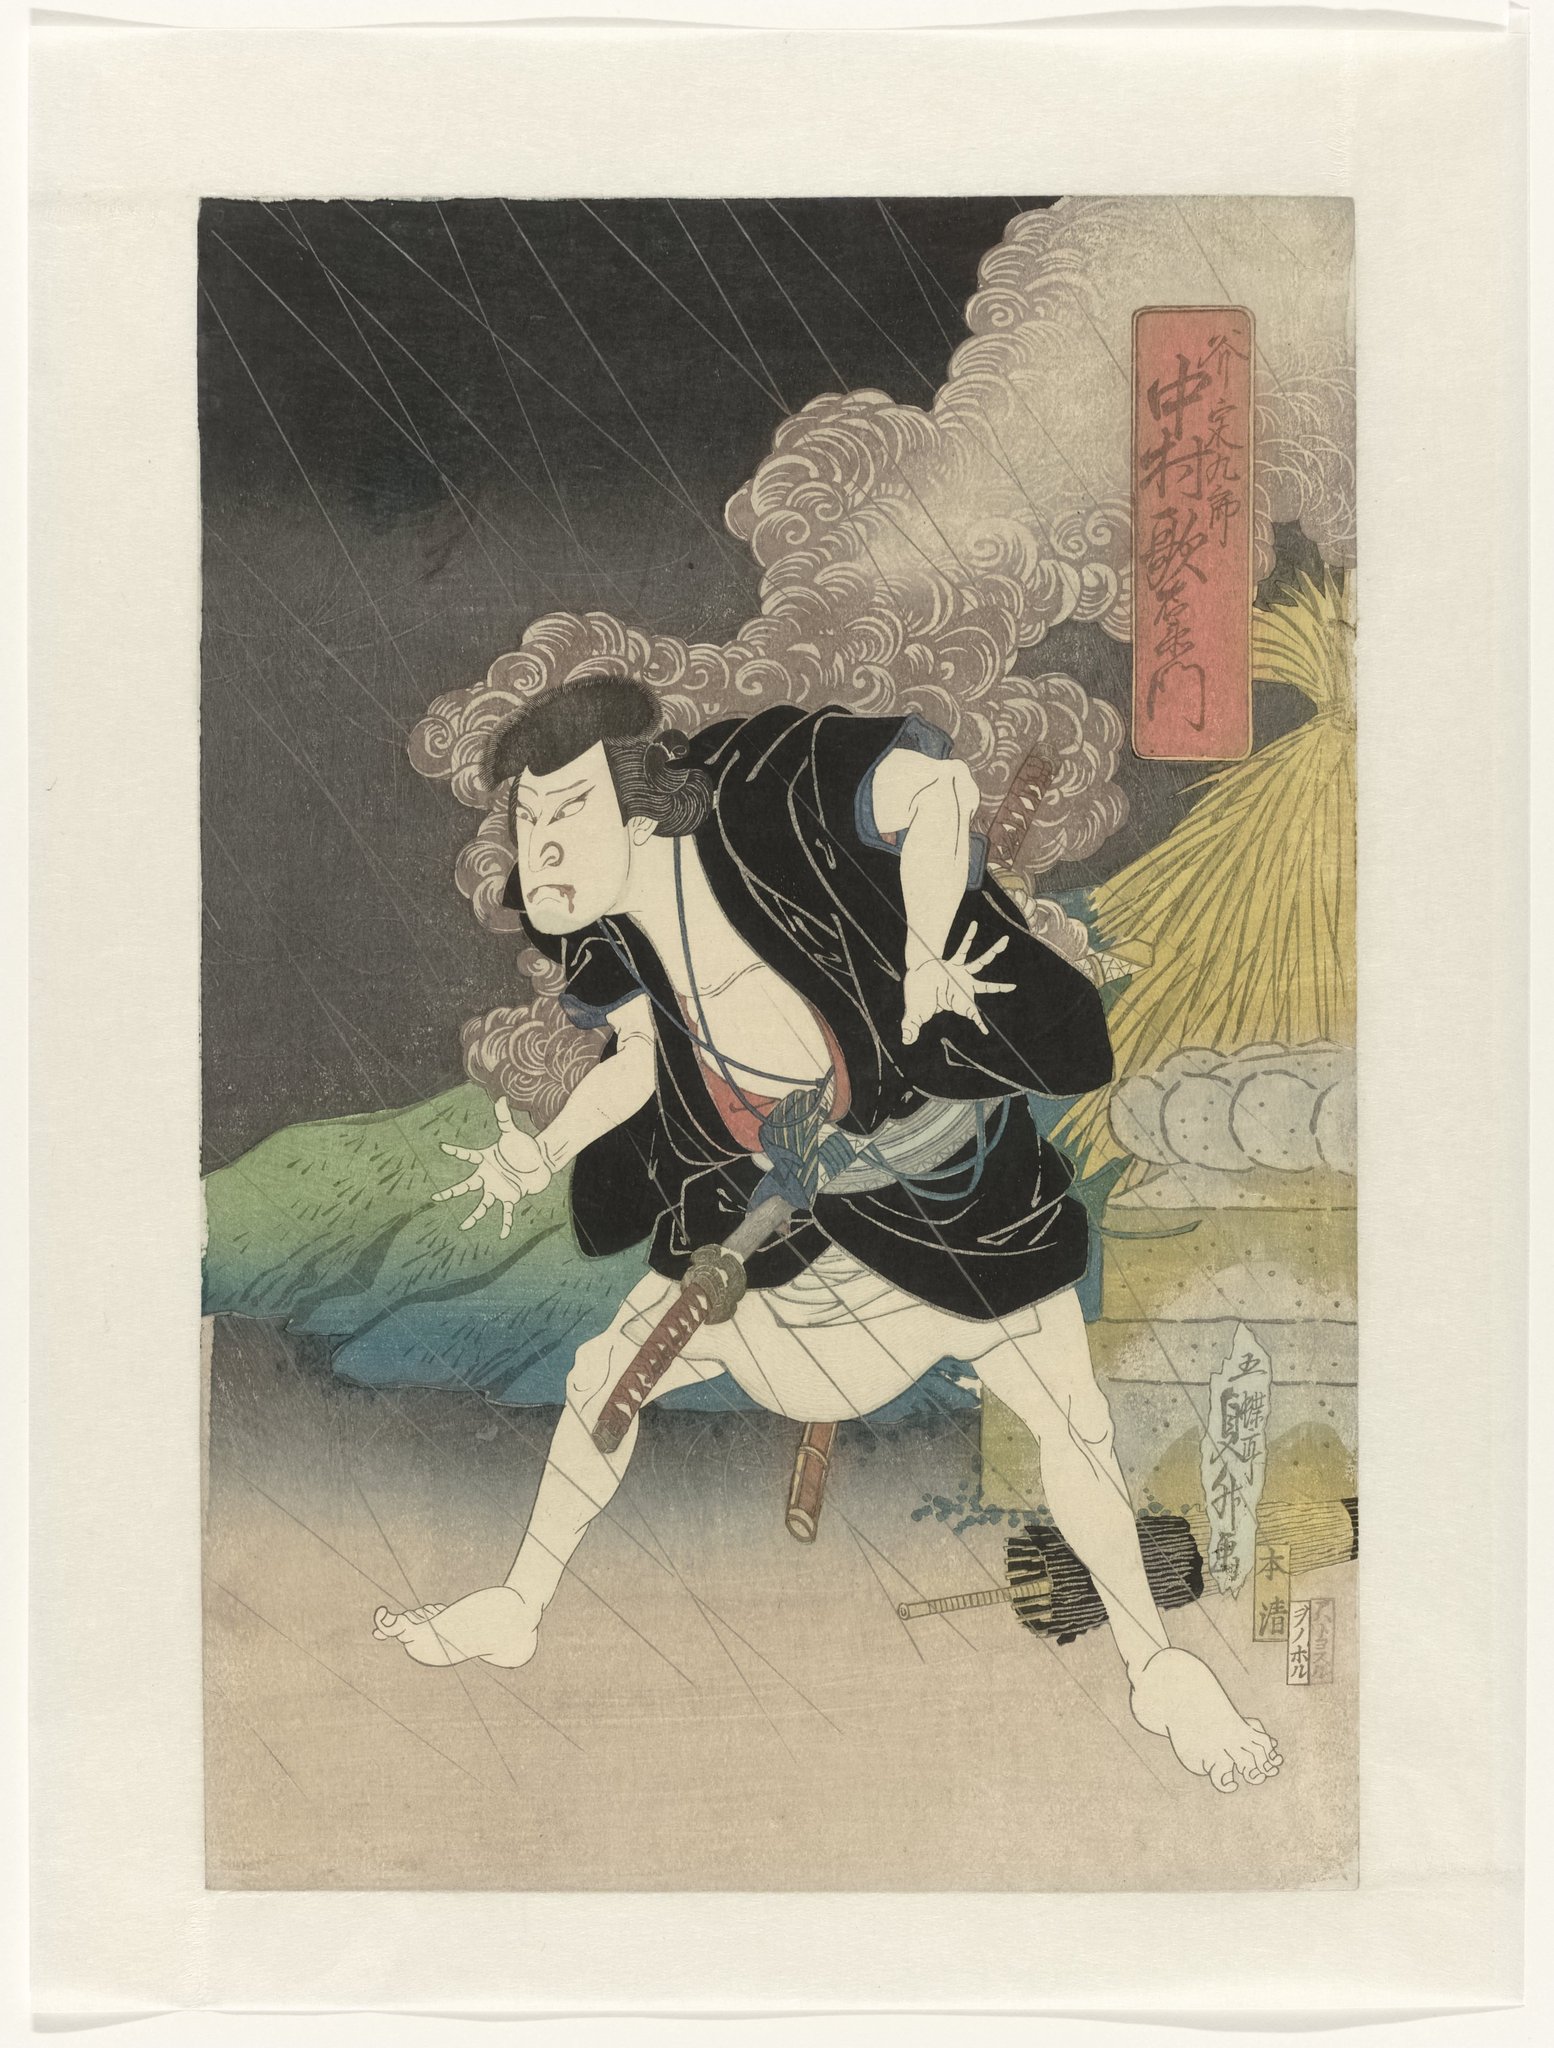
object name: print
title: Nakamura Utaemon IV als Ono Sadakurô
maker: gochôtei sadamasu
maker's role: print maker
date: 1801-1838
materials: paper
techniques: woodcut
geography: osaka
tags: japan, portrait of actor, actress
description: Nakamura Utaemon IV als Ono Sadakurô in het toneelstuk ‘Kanadehon chûshingura’, januari 1838, Naka Theater.